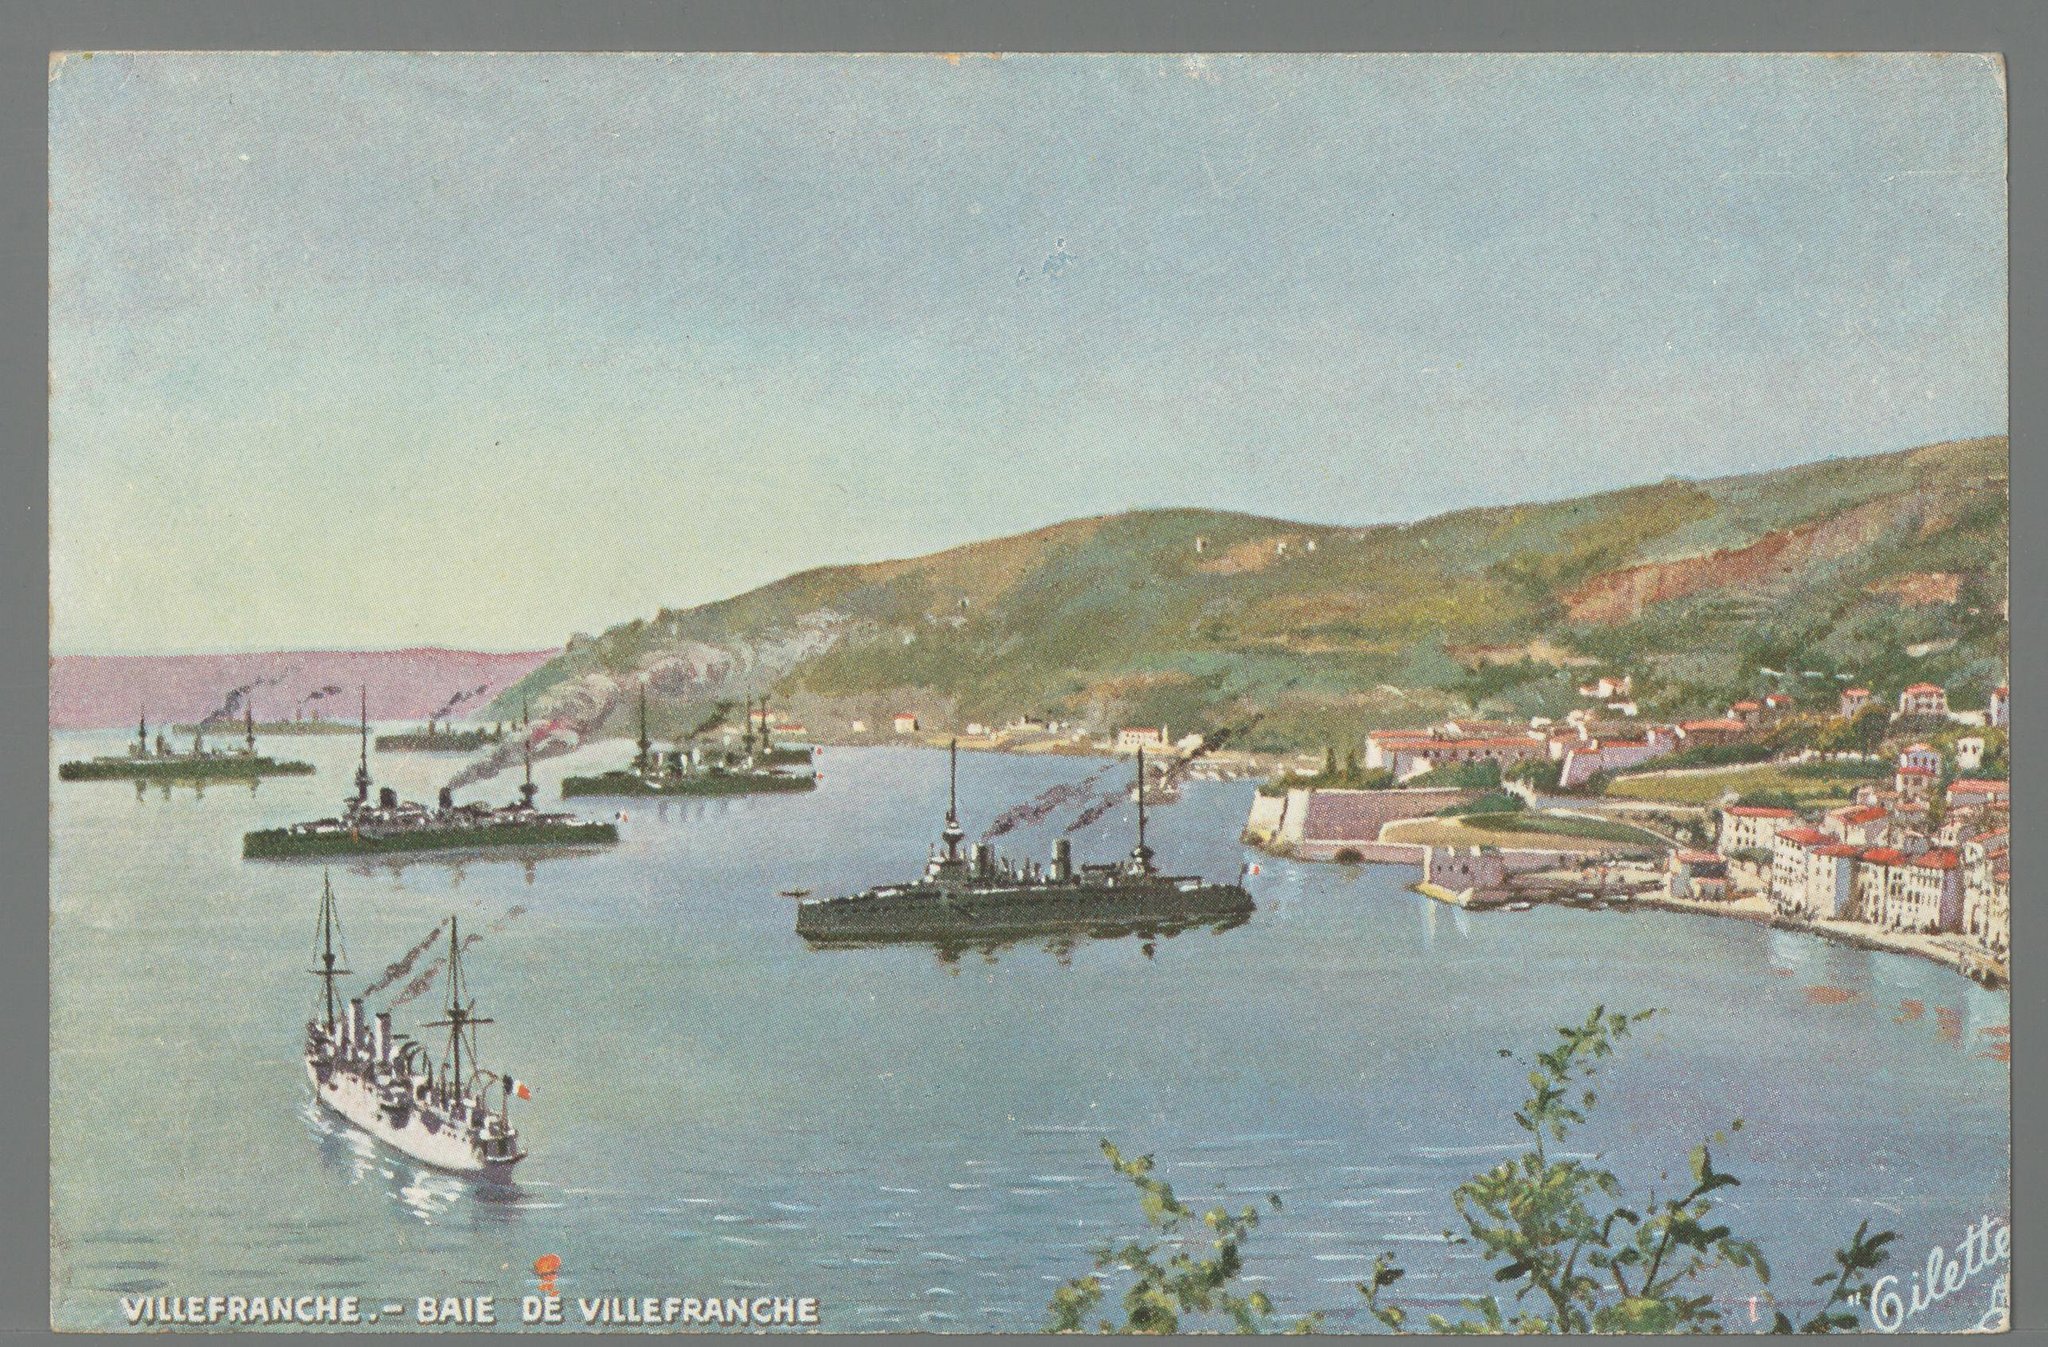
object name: ansichtkaart, prentbriefkaart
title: Beaulieu-Villefranche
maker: Anonymous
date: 1907-1909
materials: cardboard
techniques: writing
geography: paris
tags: gulf, bay, prospect of village, silhouette of village, ships (in general)